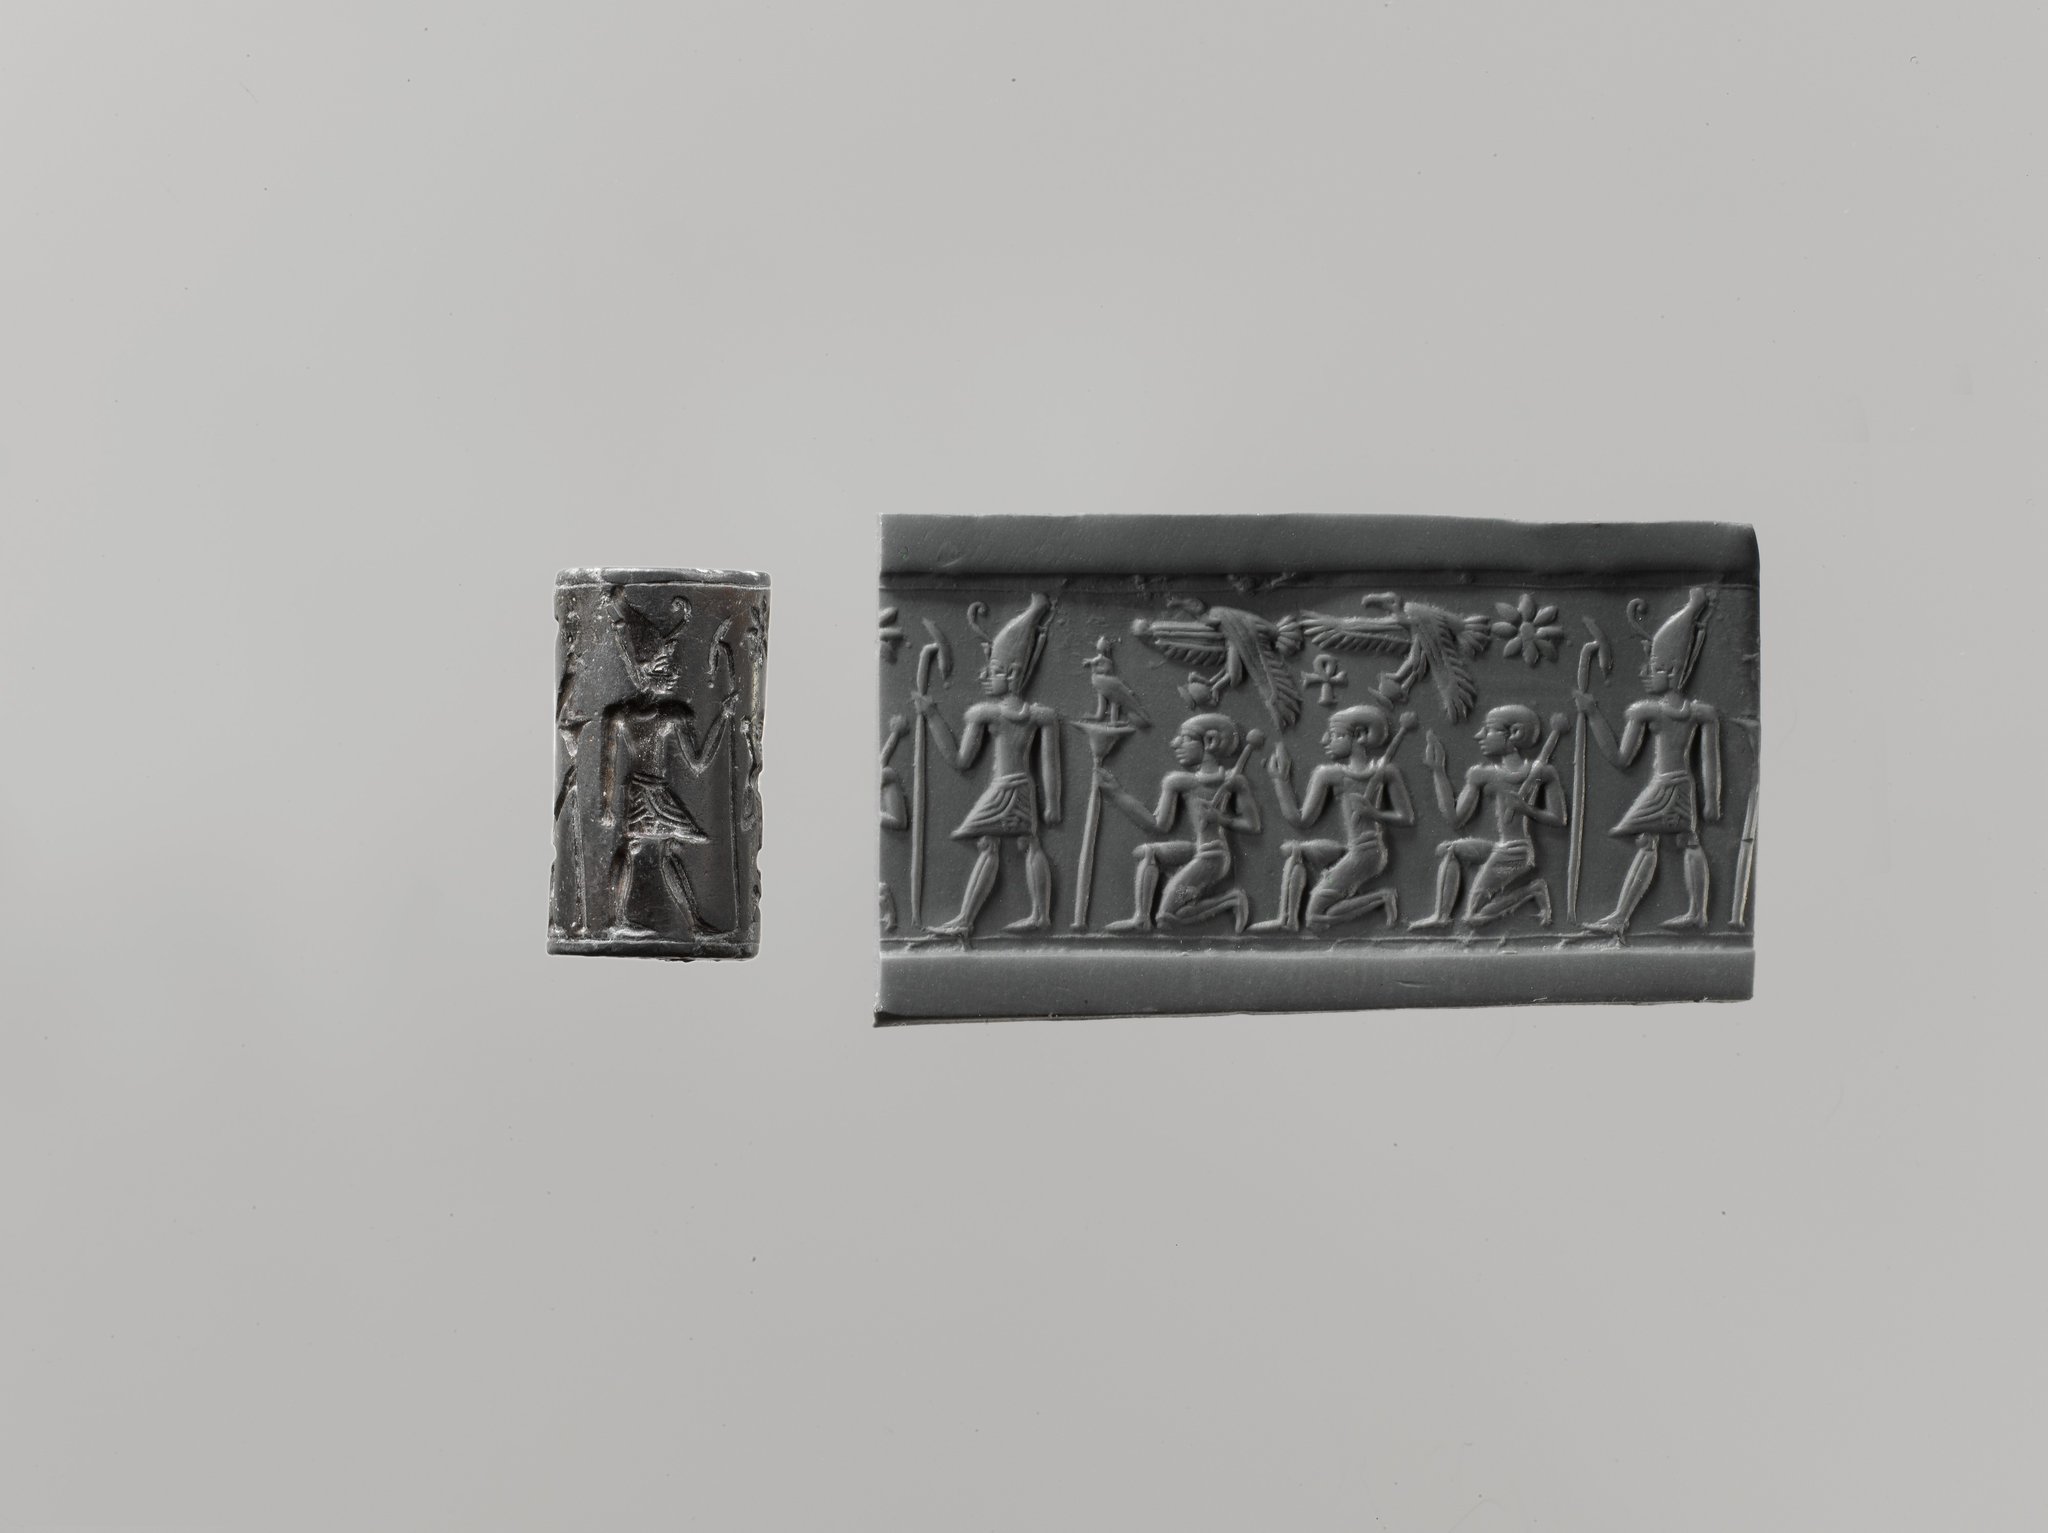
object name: cylinder seal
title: Cylinder seal and modern impression: pharaoh wearing Double Crown, kneeling figures below vultures holding shn symbols; ankh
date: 1720-1650 BCE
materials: mineral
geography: syria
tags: birds,men